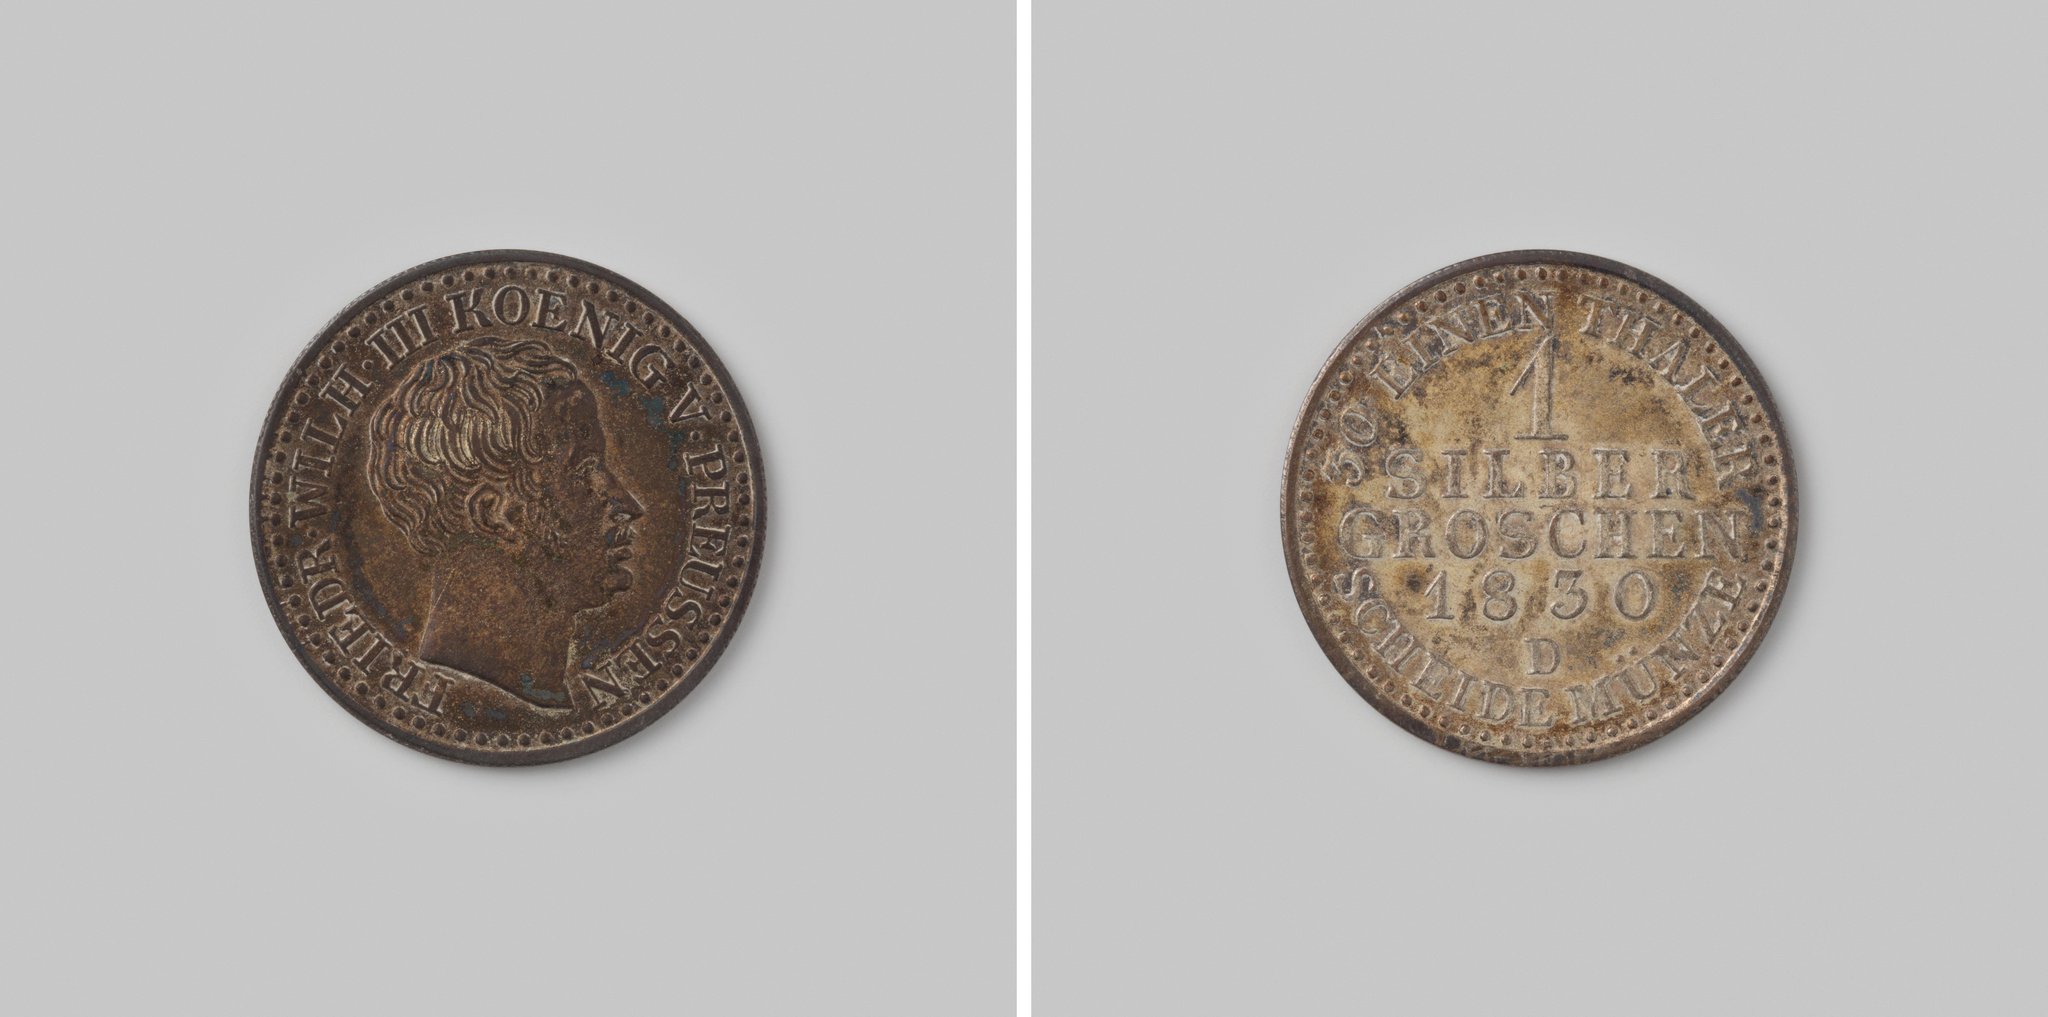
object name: coin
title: Pruisen, Friedrich Wilhelm III, silbergroschen,1830 D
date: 1830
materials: silver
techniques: striking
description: Zilveren munt. Voorzijde: hoofd van de koning naar rechts. Keerzijde: waarde-aanduiding in drie regels, waaronder jaartal. Daaronder letter D. Kartelrand.